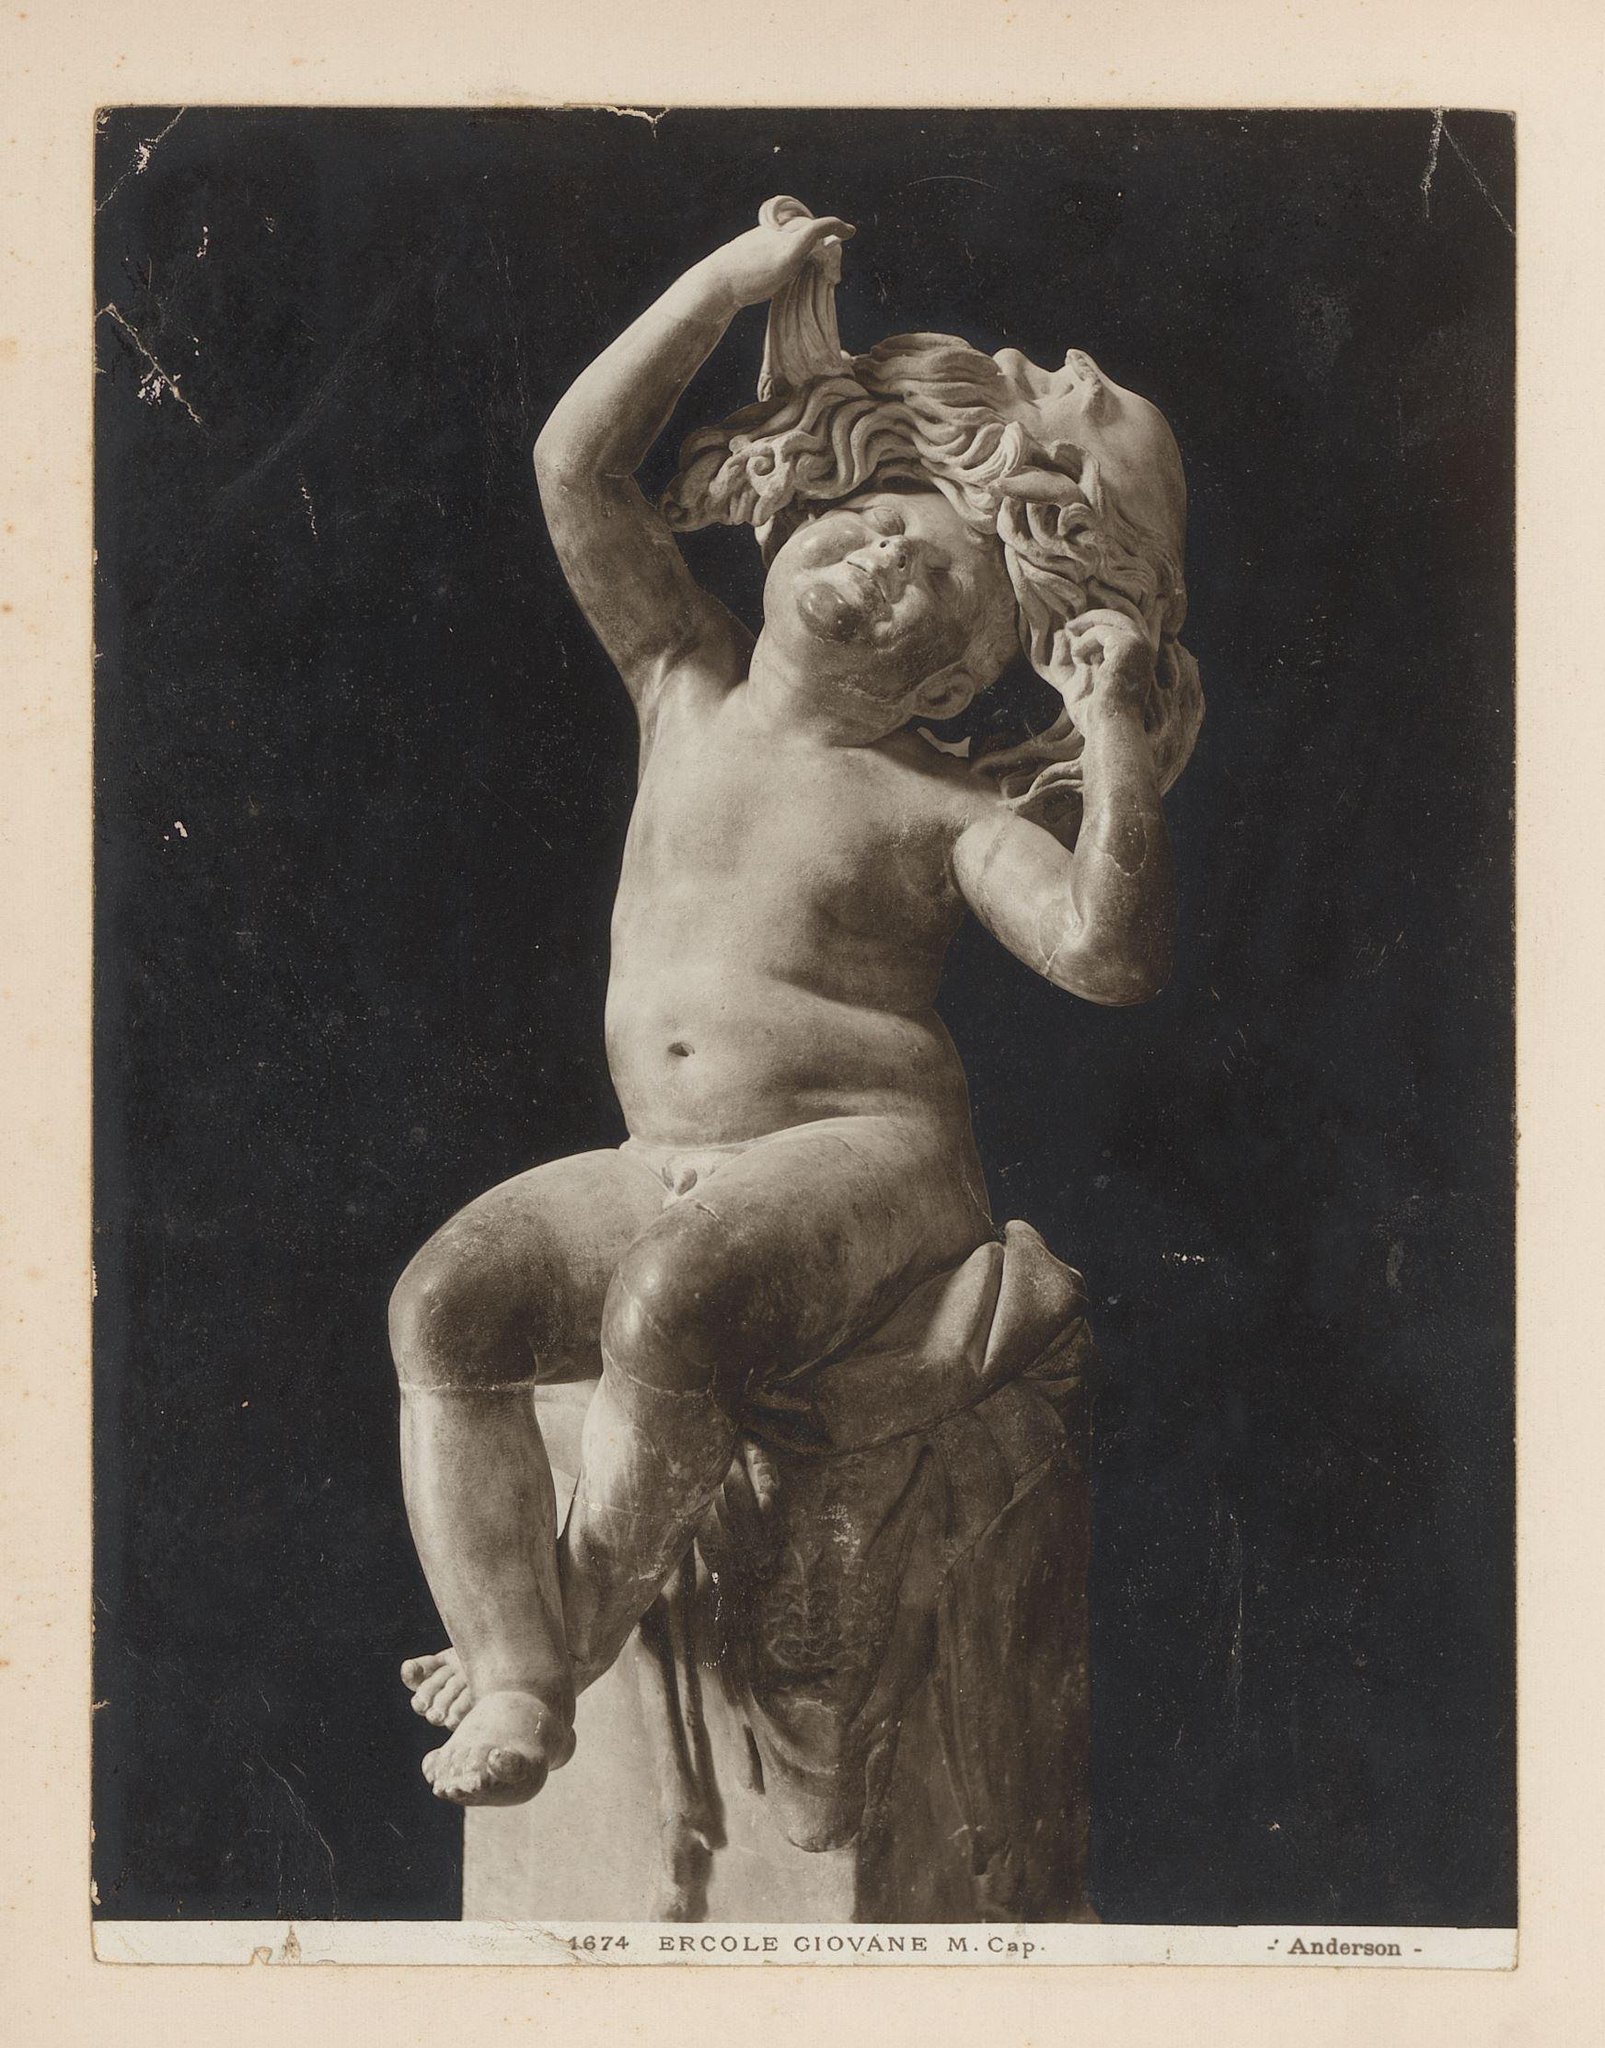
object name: album leaf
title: Sculptuur van een jongen spelend met een masker, in de Capitolijnse Musea te Rome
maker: james anderson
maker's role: fotograaf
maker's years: 1813-1877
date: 1880-1900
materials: paper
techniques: gelatin silver print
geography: capitolijnse musea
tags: playing toddler; child amusing itself, piece of sculpture, reproduction of a piece of sculpture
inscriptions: inscription: ‘1674 Ercole Giovane M. Cap. - Anderson -’